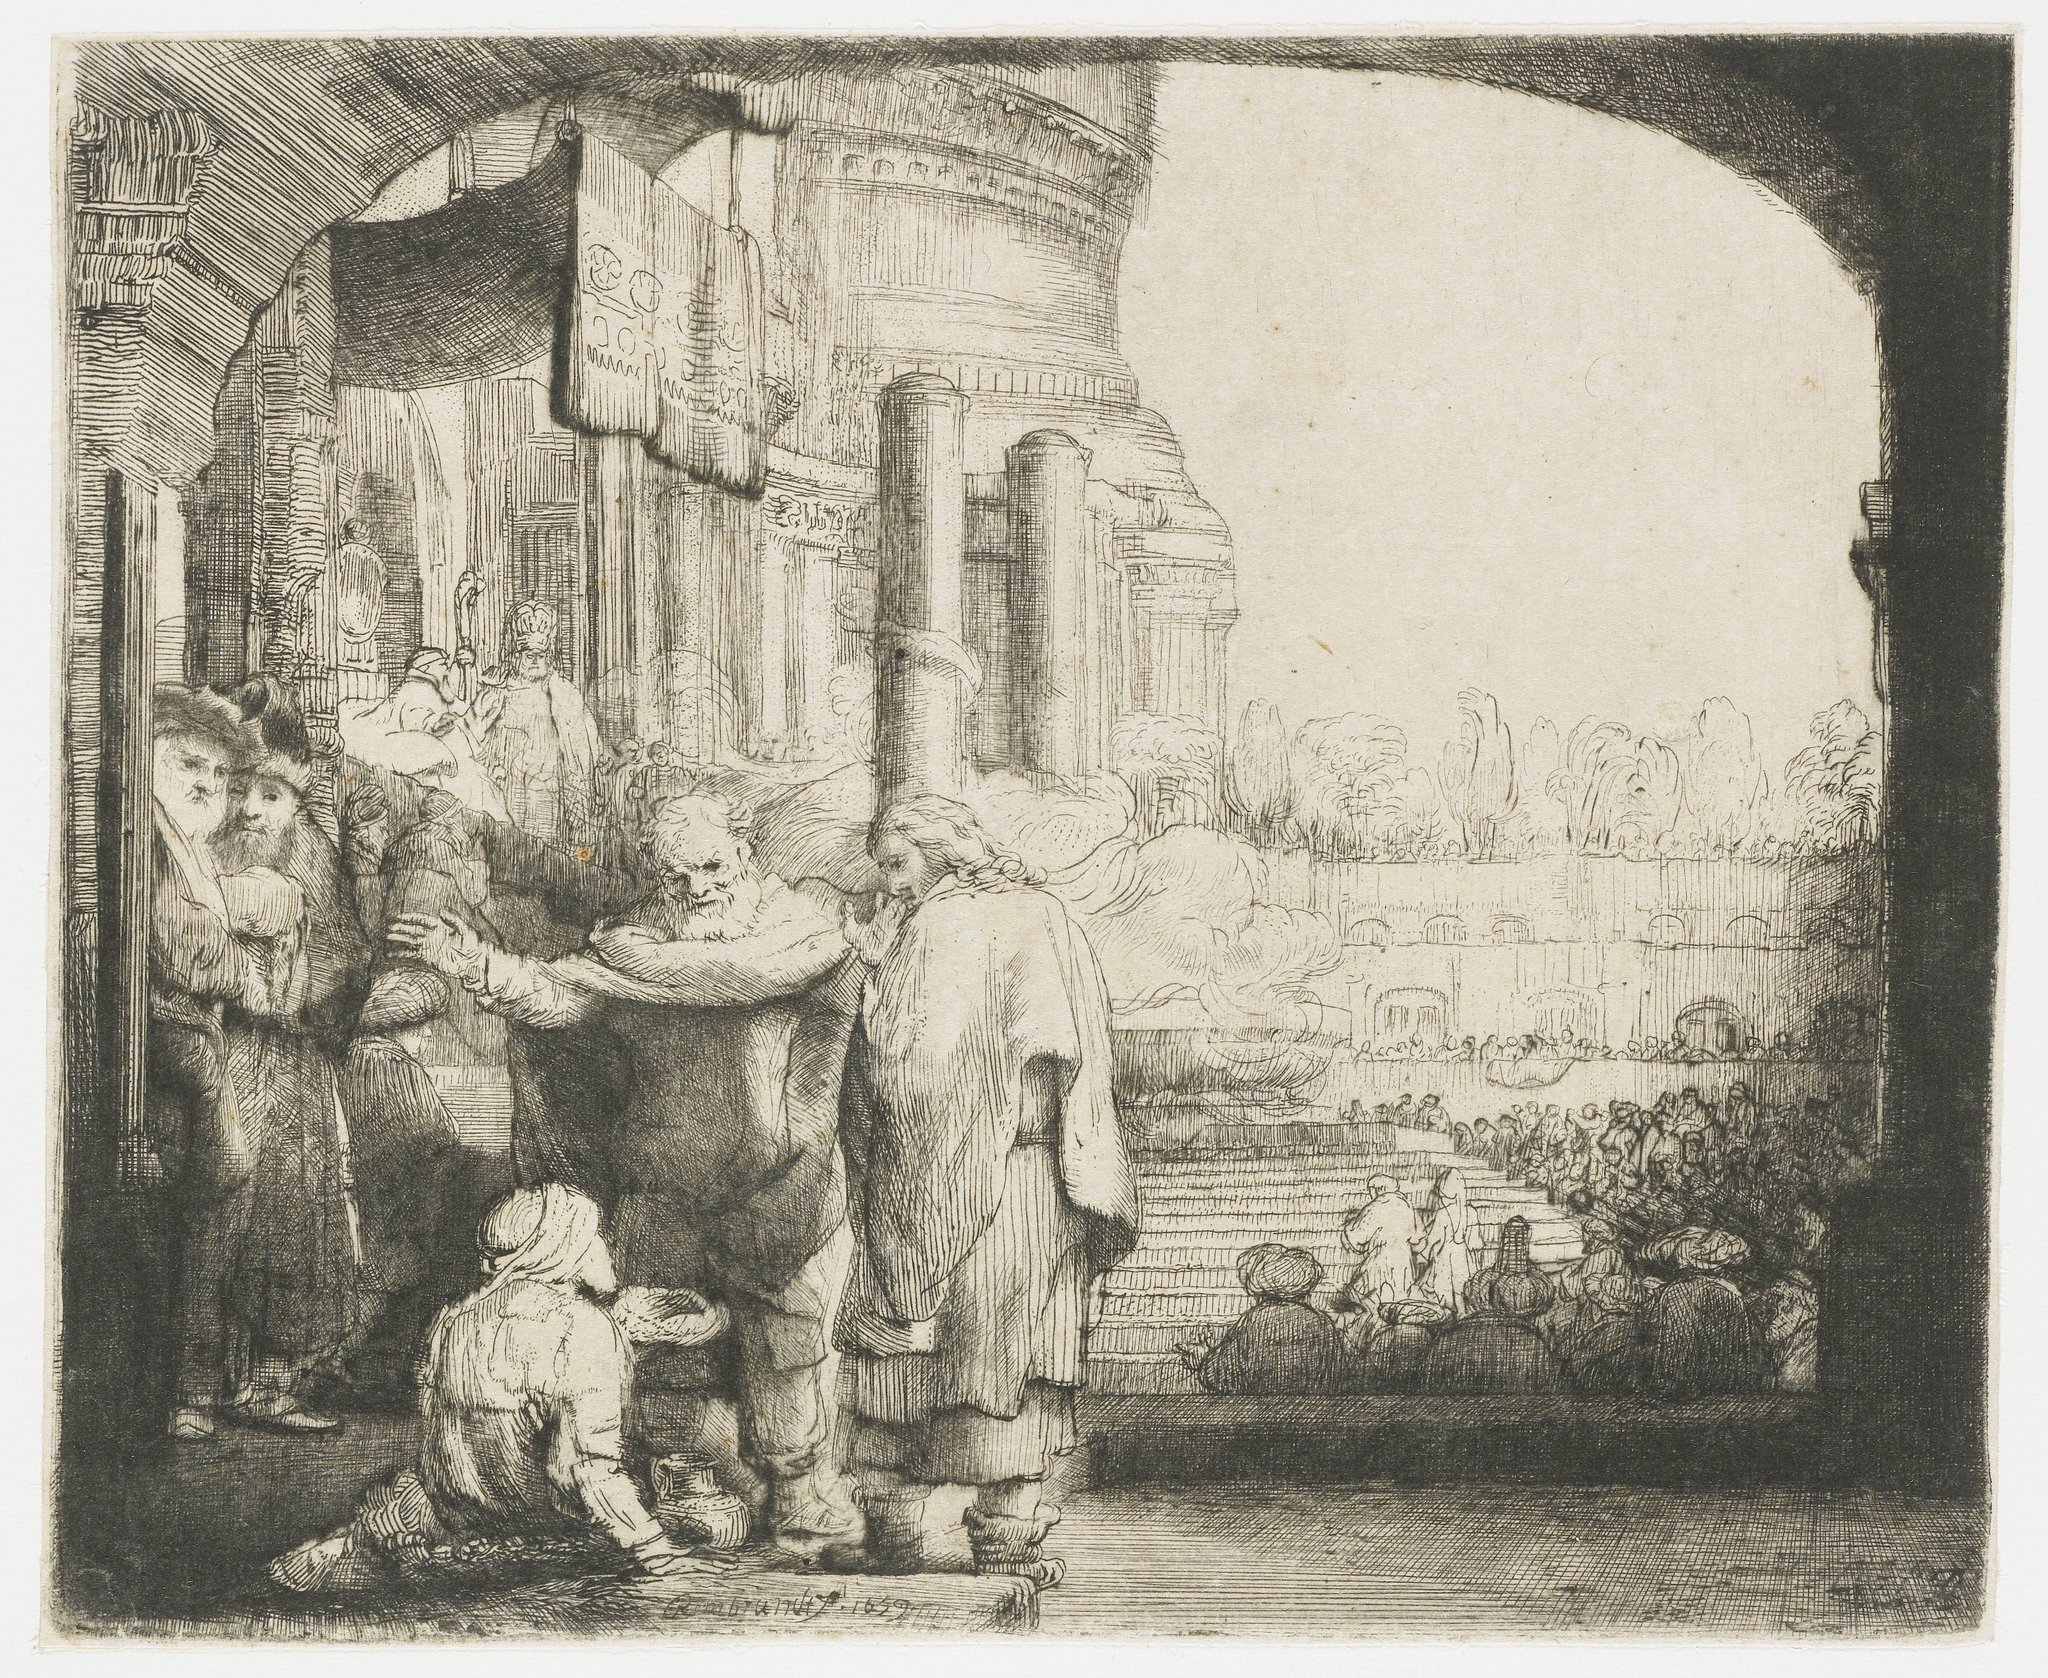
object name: print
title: Peter and John healing the cripple at the gate of the temple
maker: rembrandt van rijn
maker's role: draughtsman, painter, print maker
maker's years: 1606-1669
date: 1659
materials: paper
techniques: drypoint, etching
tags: healing of a lame beggar at the beautiful gate of the temple by peter and john (acts 3 - 4:31)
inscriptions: signature and date: ‘Rembrandt f. 1659’, collector's mark: Lugt 240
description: De voorstelling is gebaseerd op de tekst uit Handelingen 3:4-31.